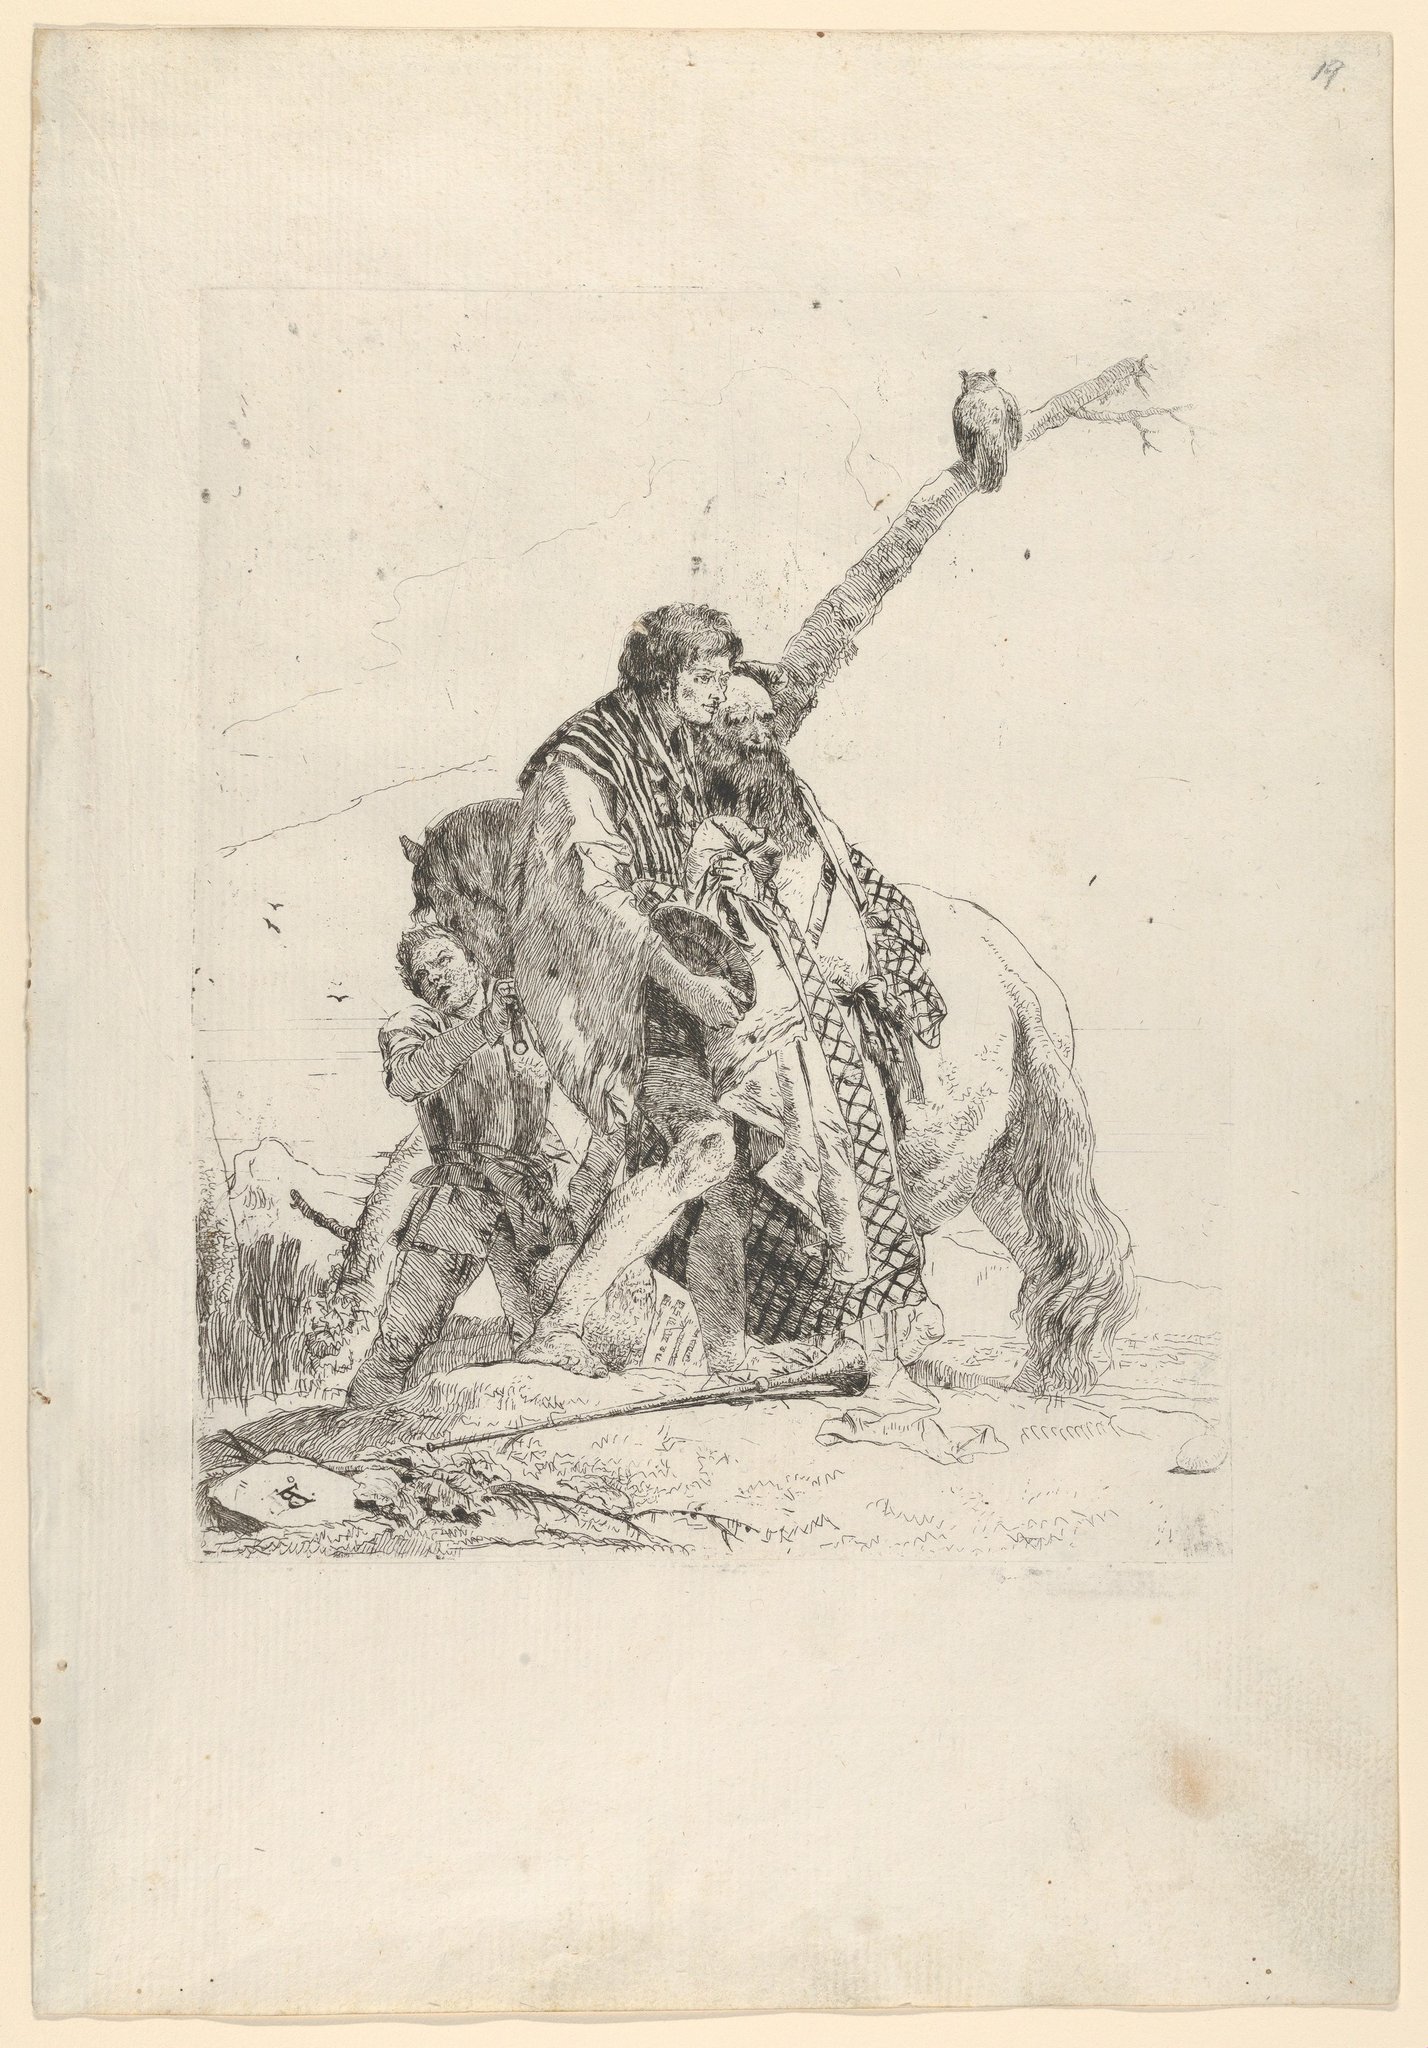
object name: print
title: Three Men standing beside a Horse, from the Scherzi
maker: giovanni battista tiepolo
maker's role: artist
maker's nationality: italian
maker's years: 1696-1770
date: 1740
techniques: etching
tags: men,owls,horses